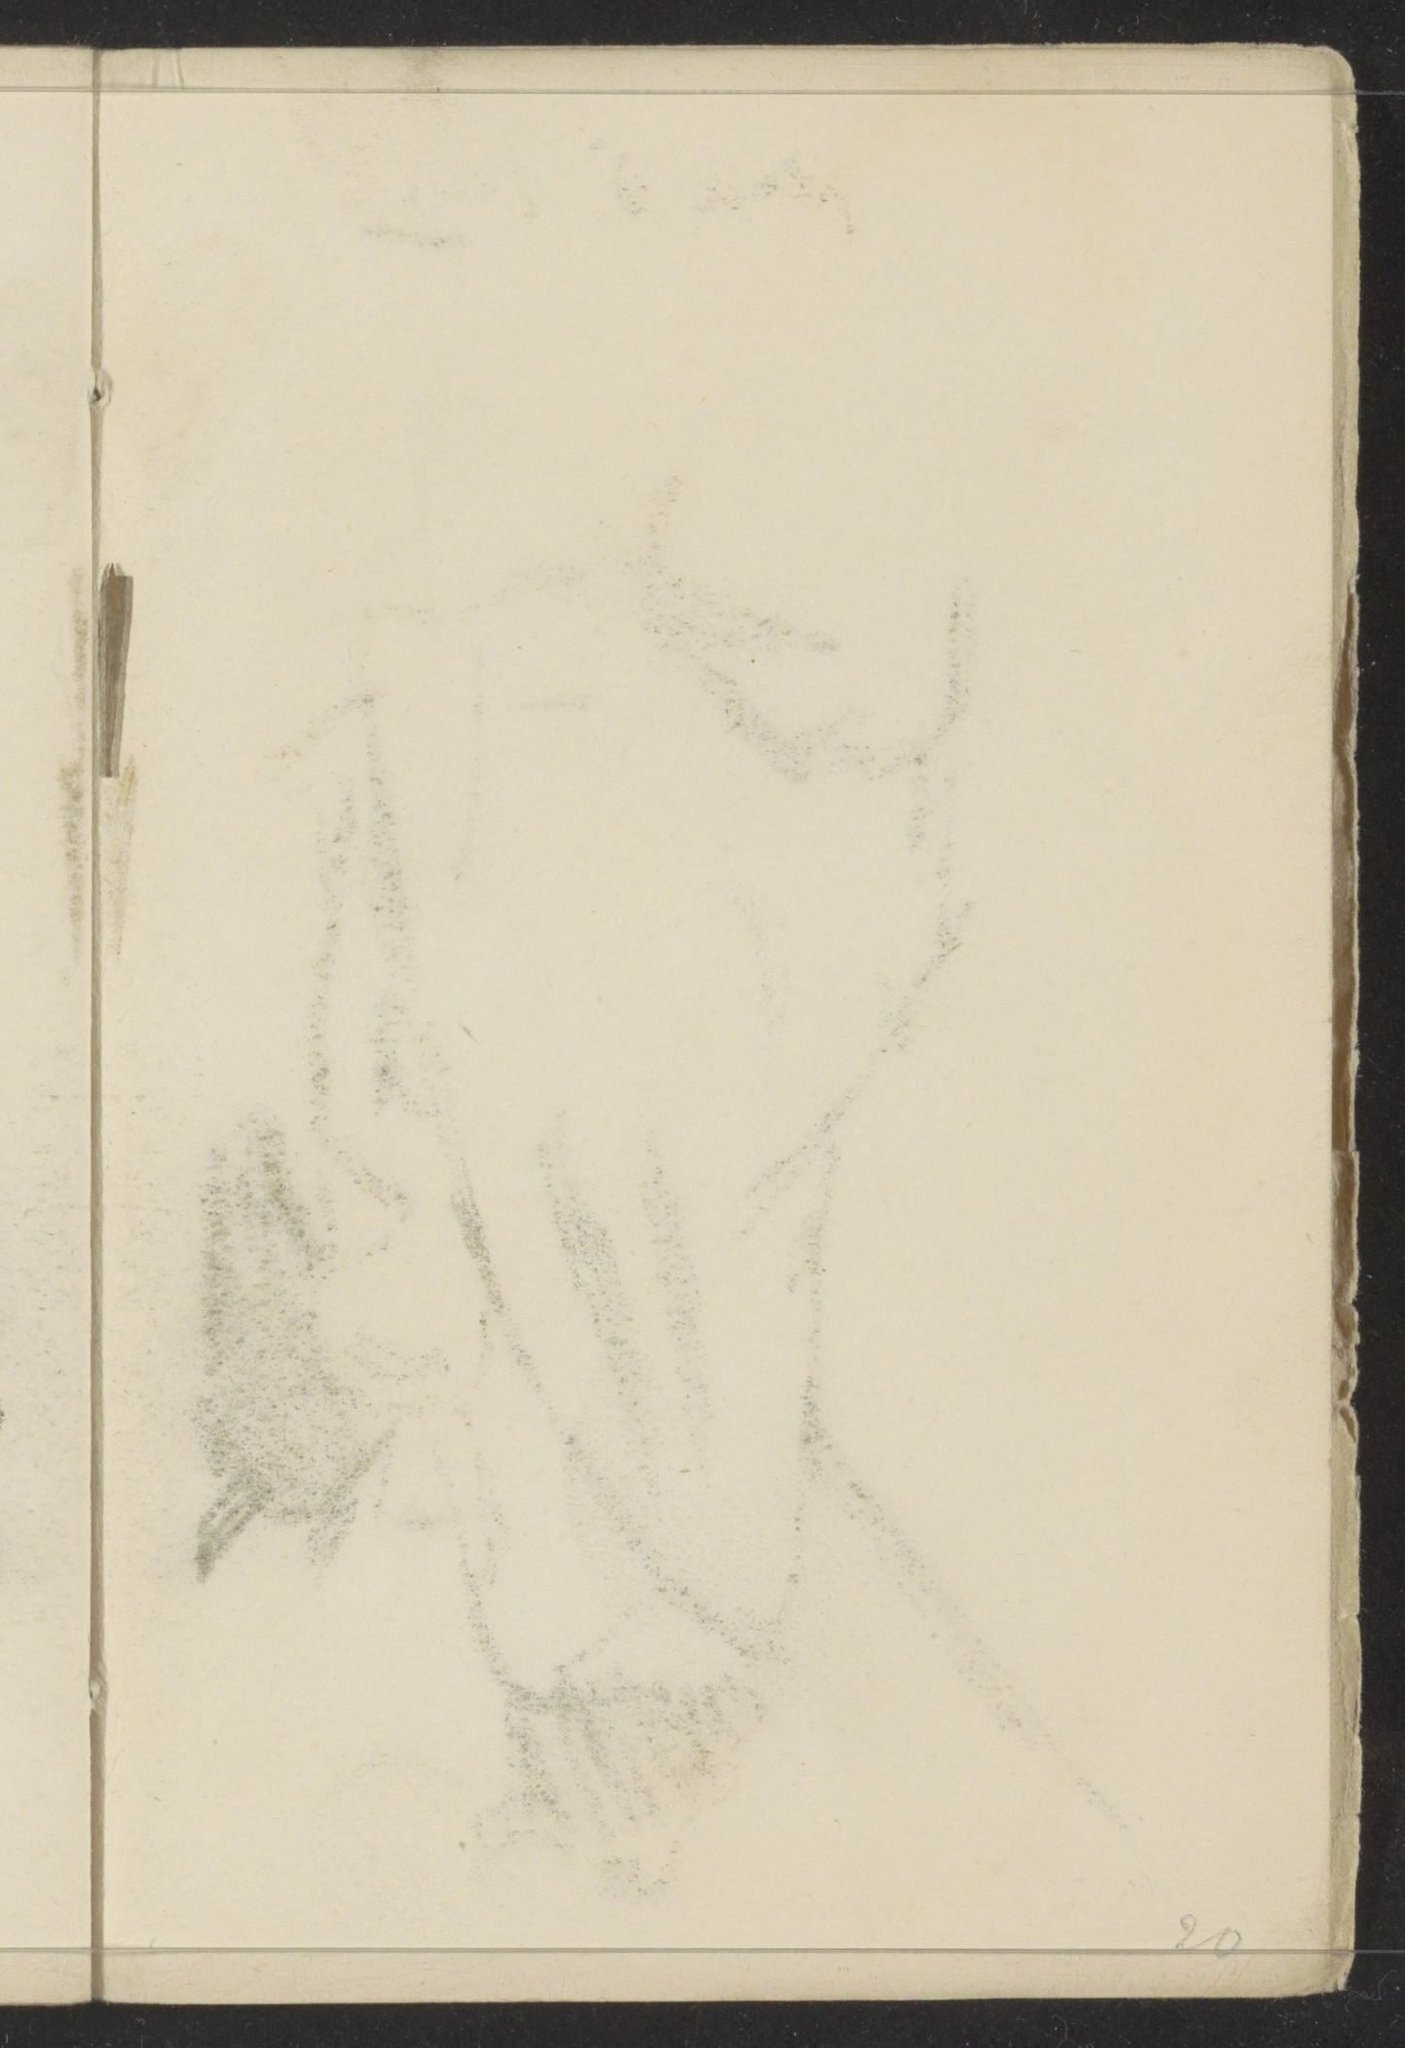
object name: sketchbook leaf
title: Abklatsch van de krijttekening op blad 18 verso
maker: isaac israels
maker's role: draughtsman, painter, print maker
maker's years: 1865-1934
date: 1887-1934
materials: paper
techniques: printmaking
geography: paris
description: Blad 20 recto uit schetsboek LIX met 21 bladen.